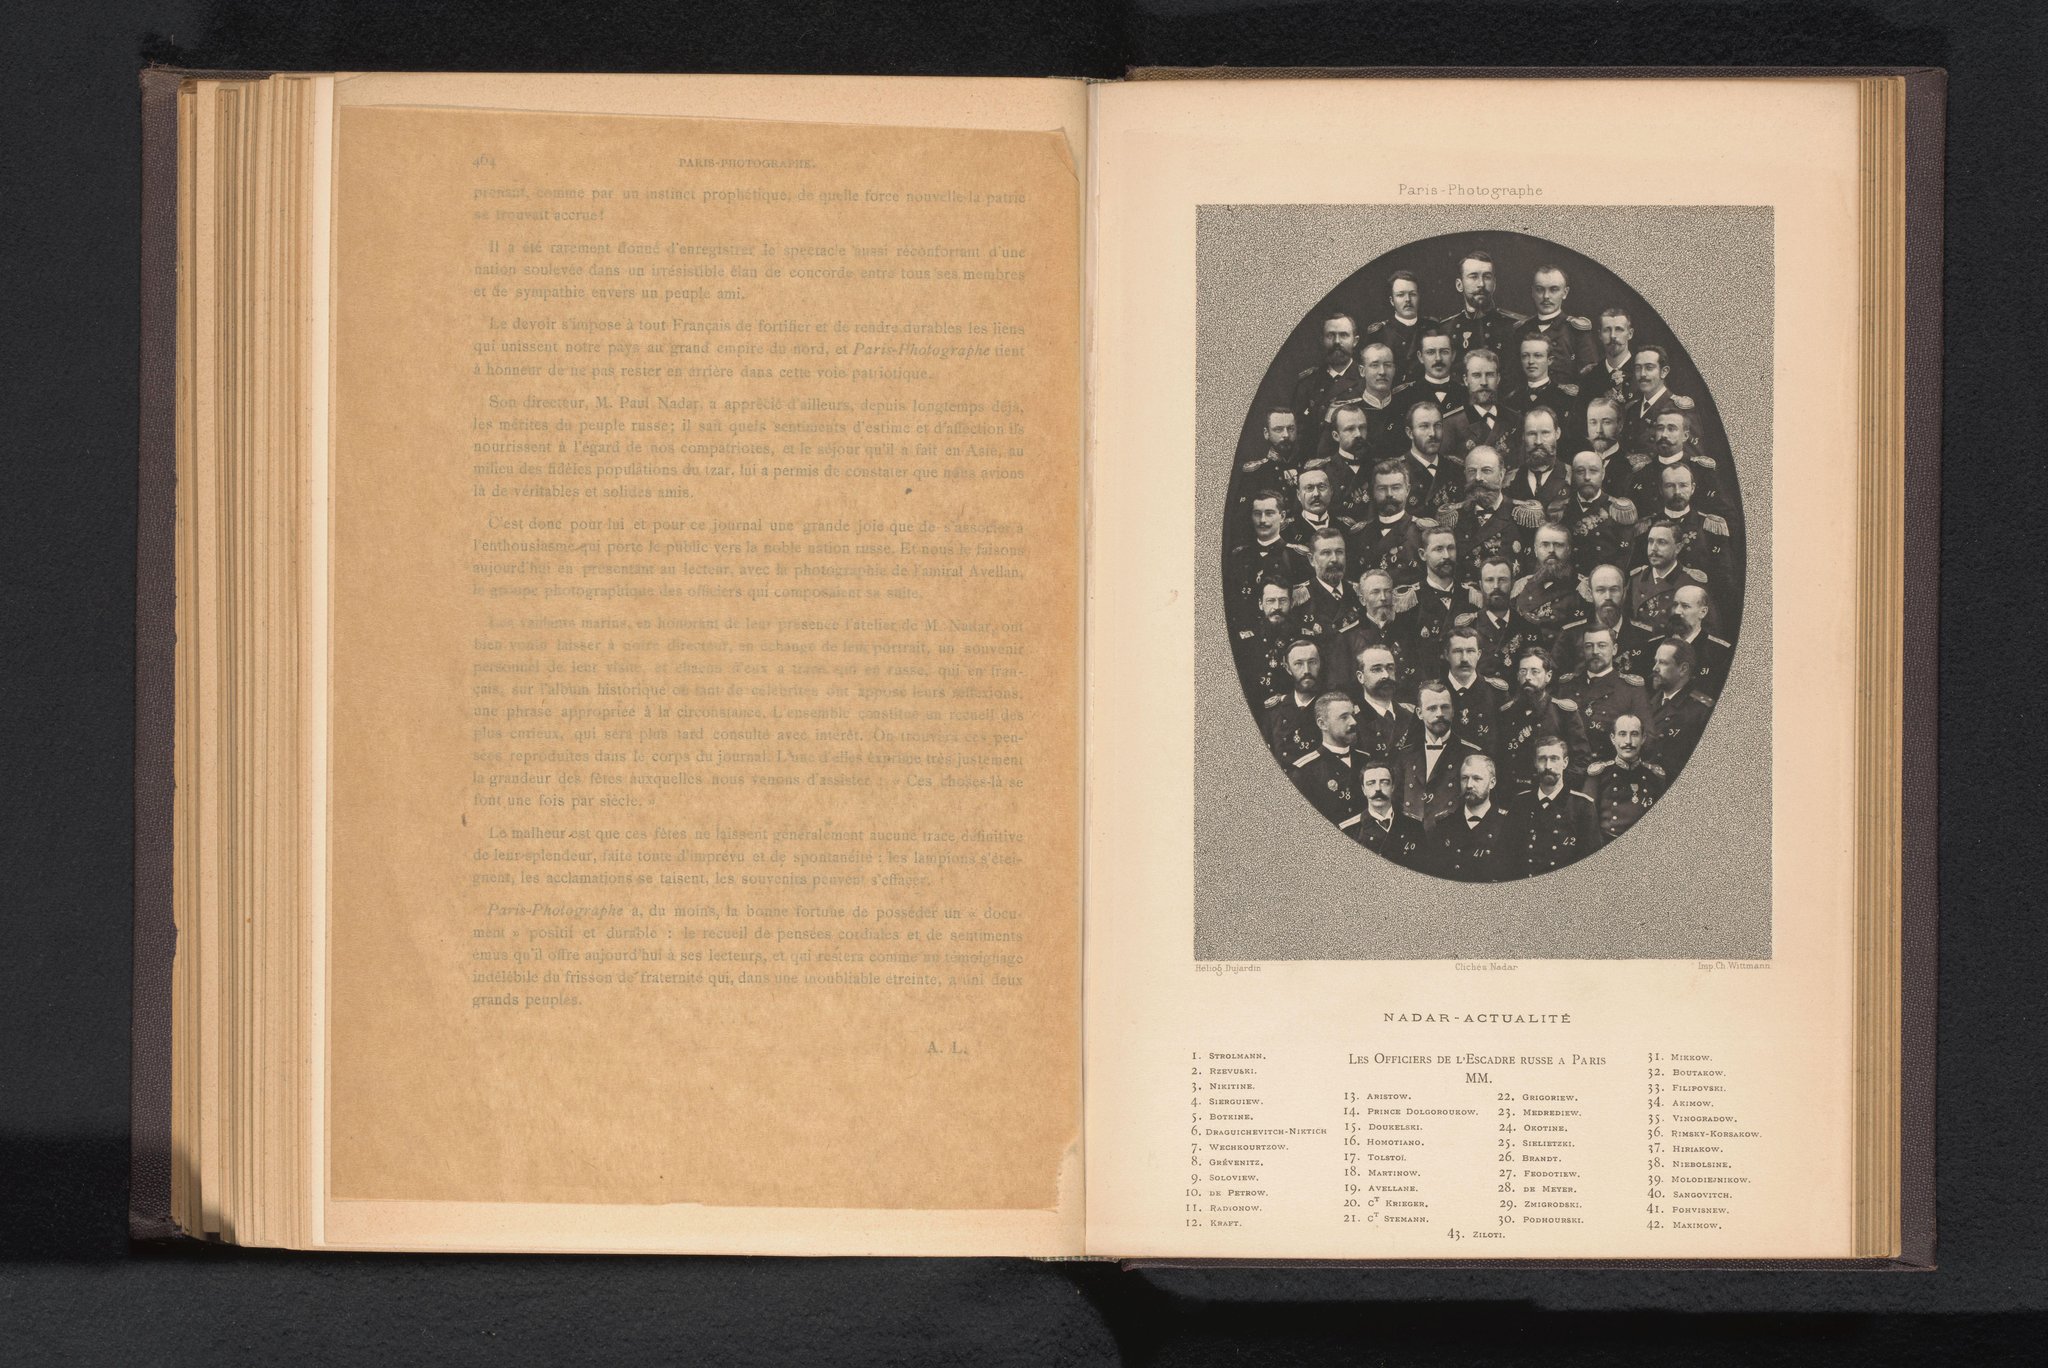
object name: page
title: Les Officiers de l'Escadre Russe a Paris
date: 1883-1893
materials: paper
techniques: photoaquatint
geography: france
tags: officer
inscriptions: name: ‘1. Strolmann (...) 43. Ziloti.’